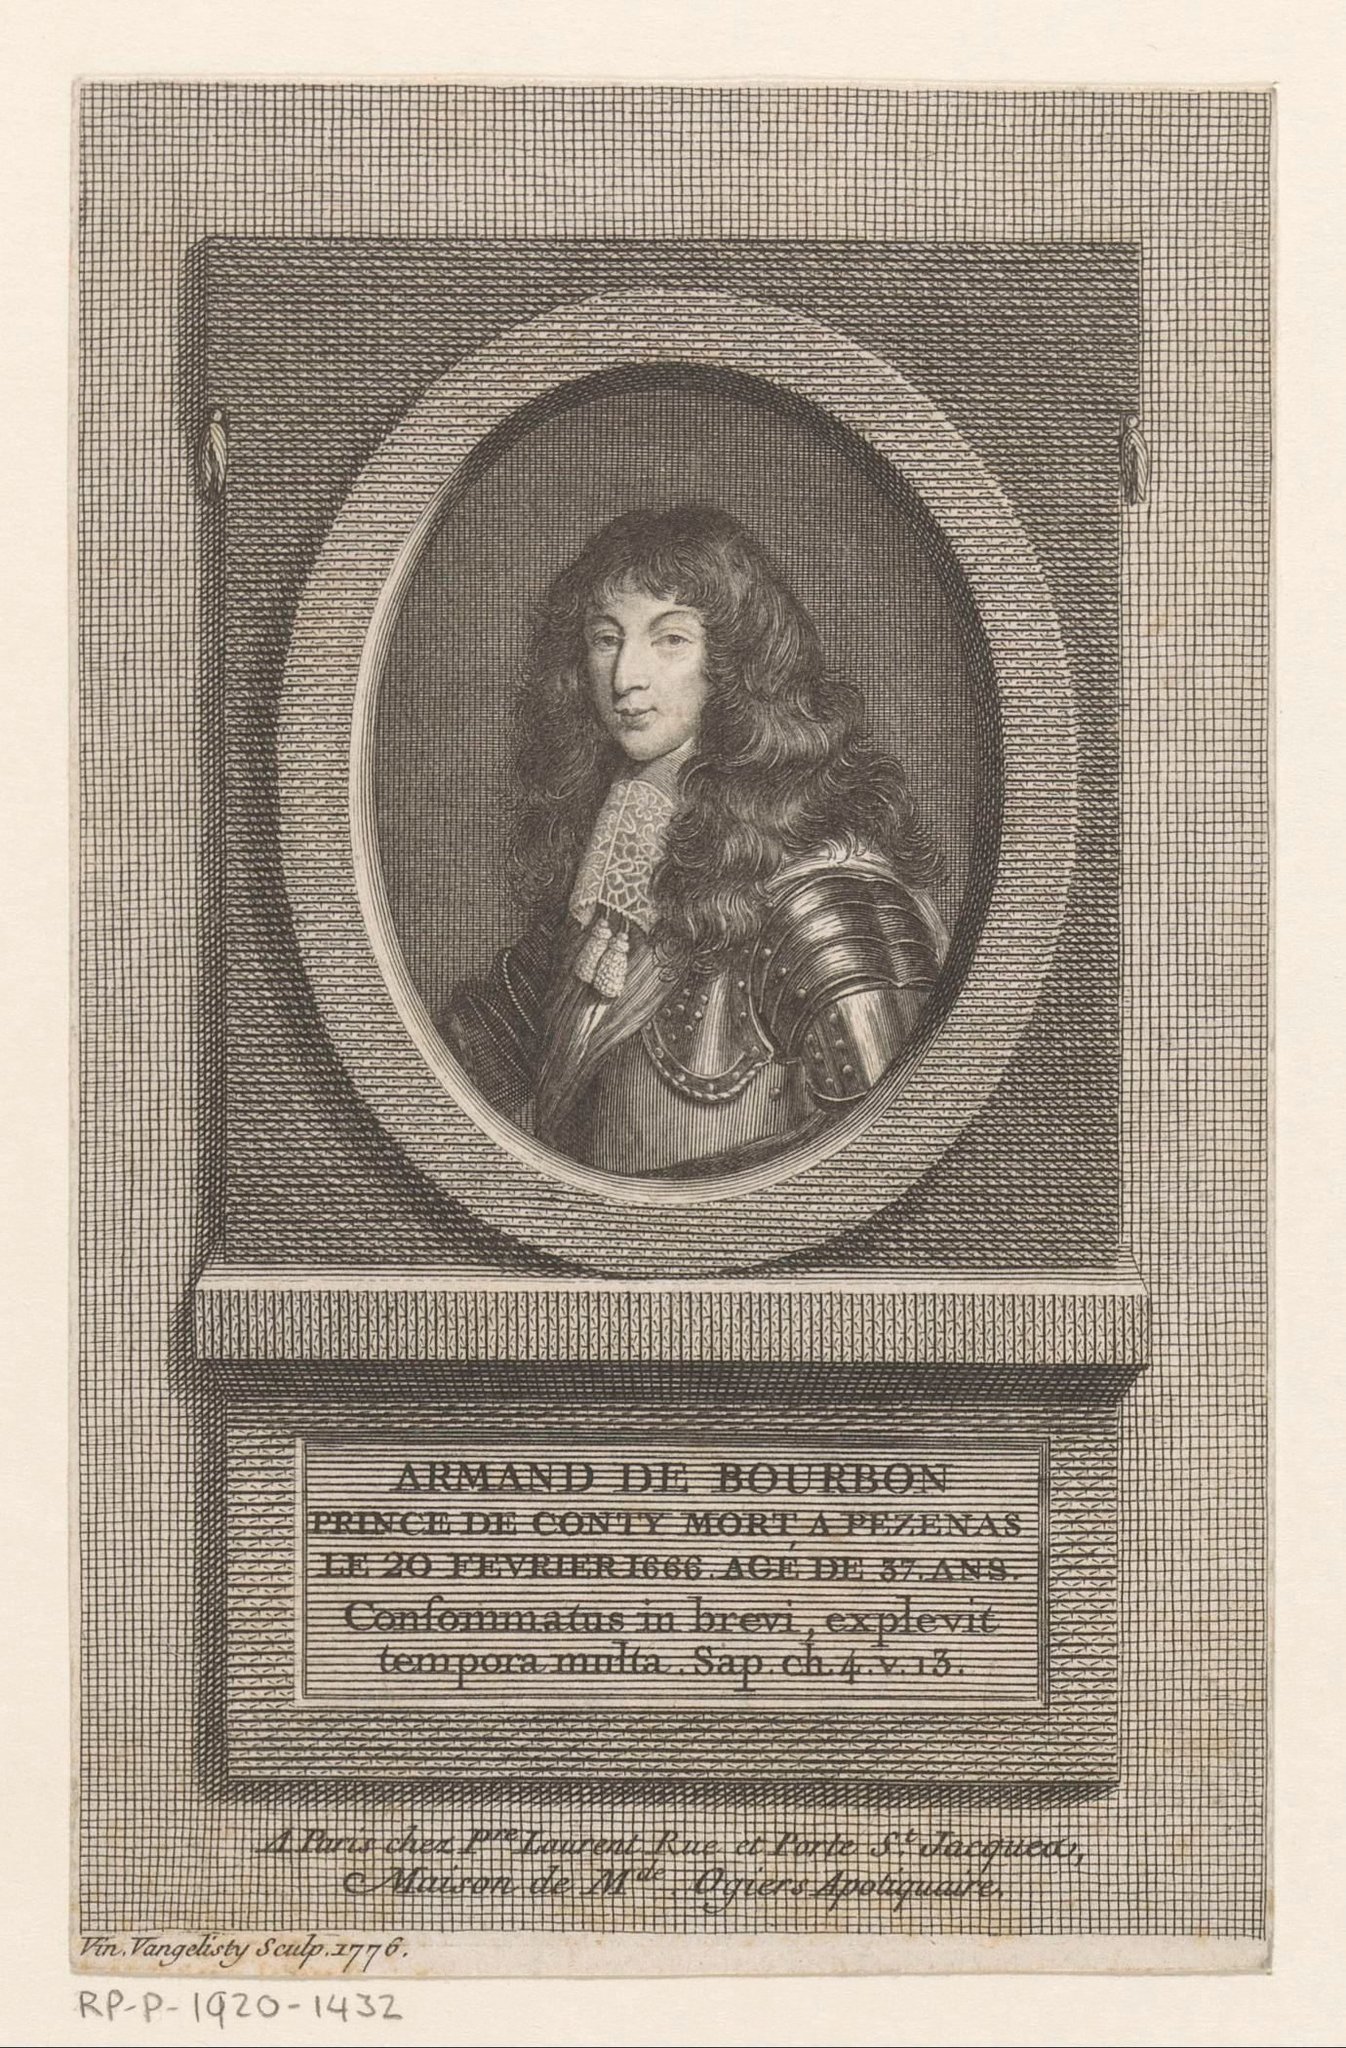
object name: print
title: Portret van Armand de Bourbon-Condé, prins van Conti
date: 1776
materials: paper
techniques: engraving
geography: paris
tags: paris, historical persons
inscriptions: collector's mark: Lugt 2228